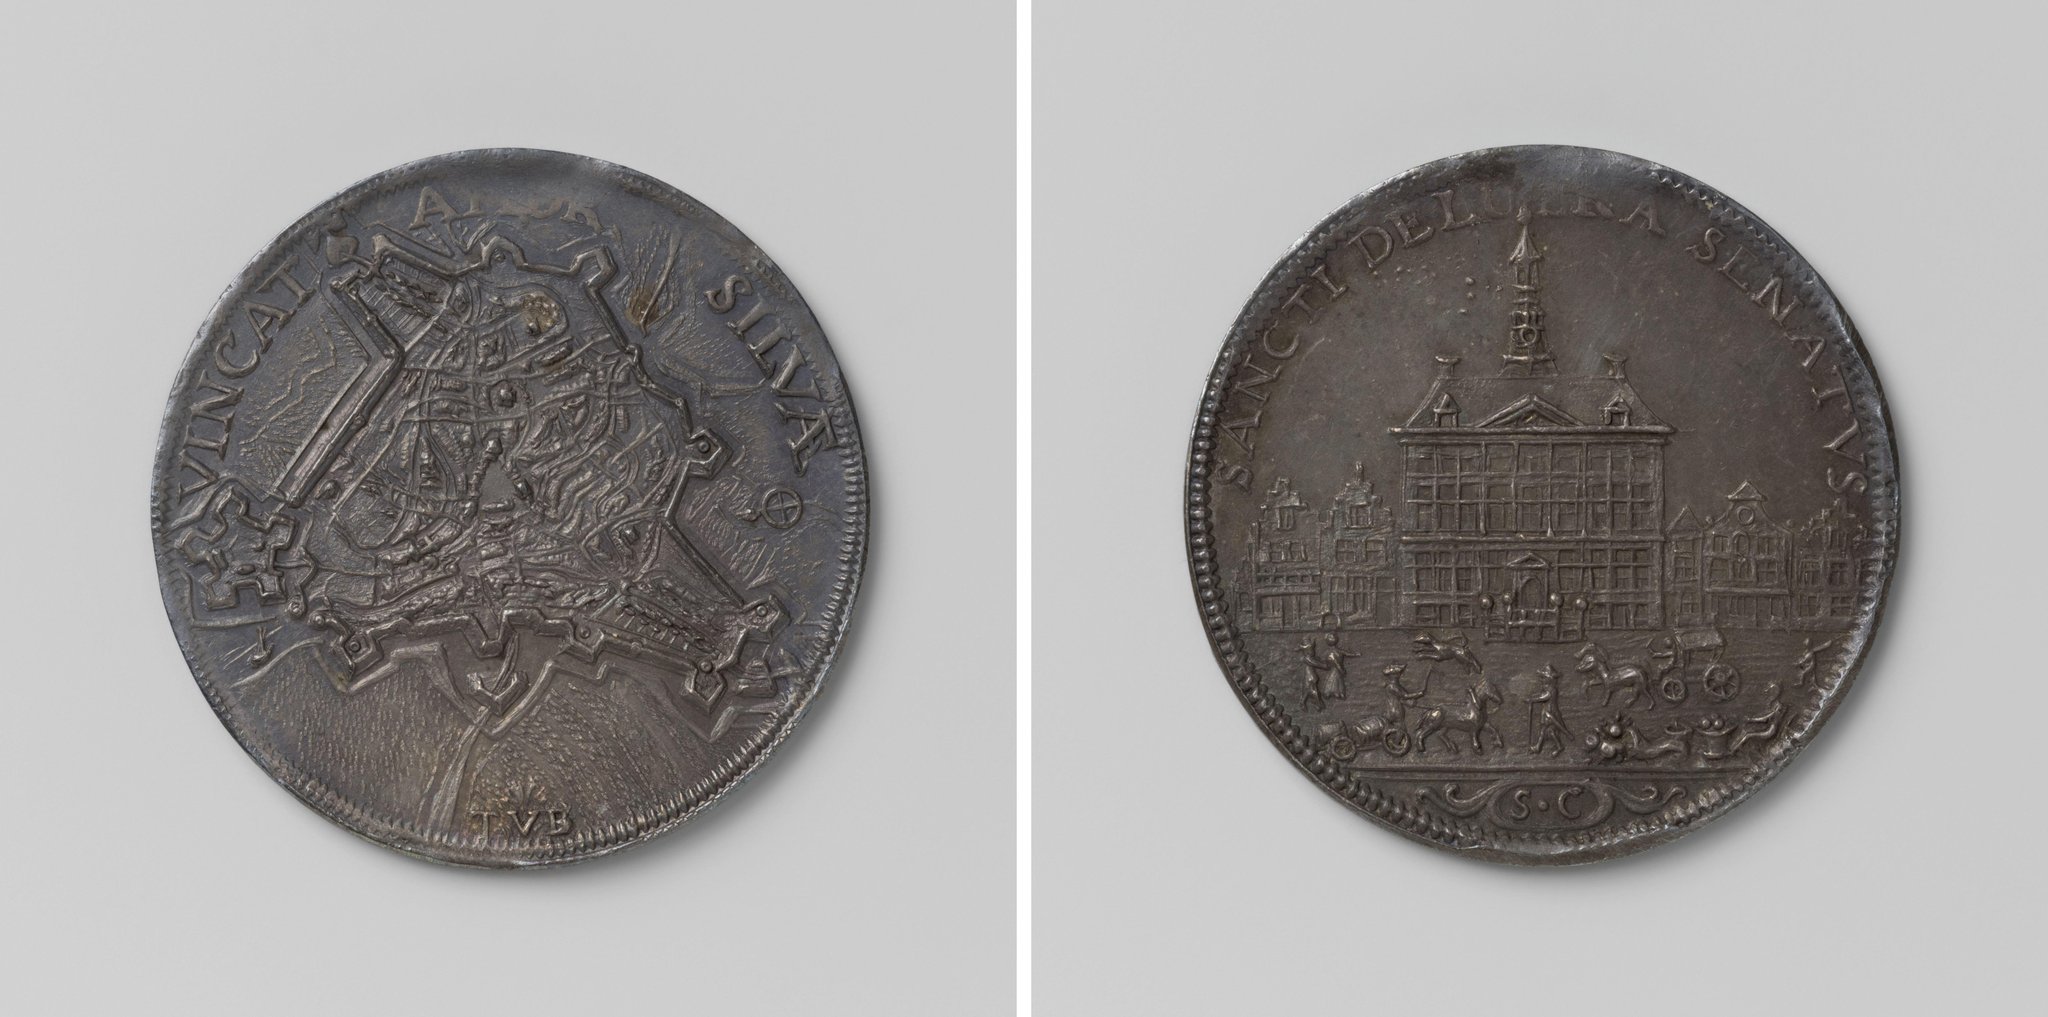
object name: council medal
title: Vroedschapspenning van de stad 's-Hertogenbosch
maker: theodorus casparus van berckel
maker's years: 1680-1734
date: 1726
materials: silver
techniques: striking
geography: den bosch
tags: den bosch